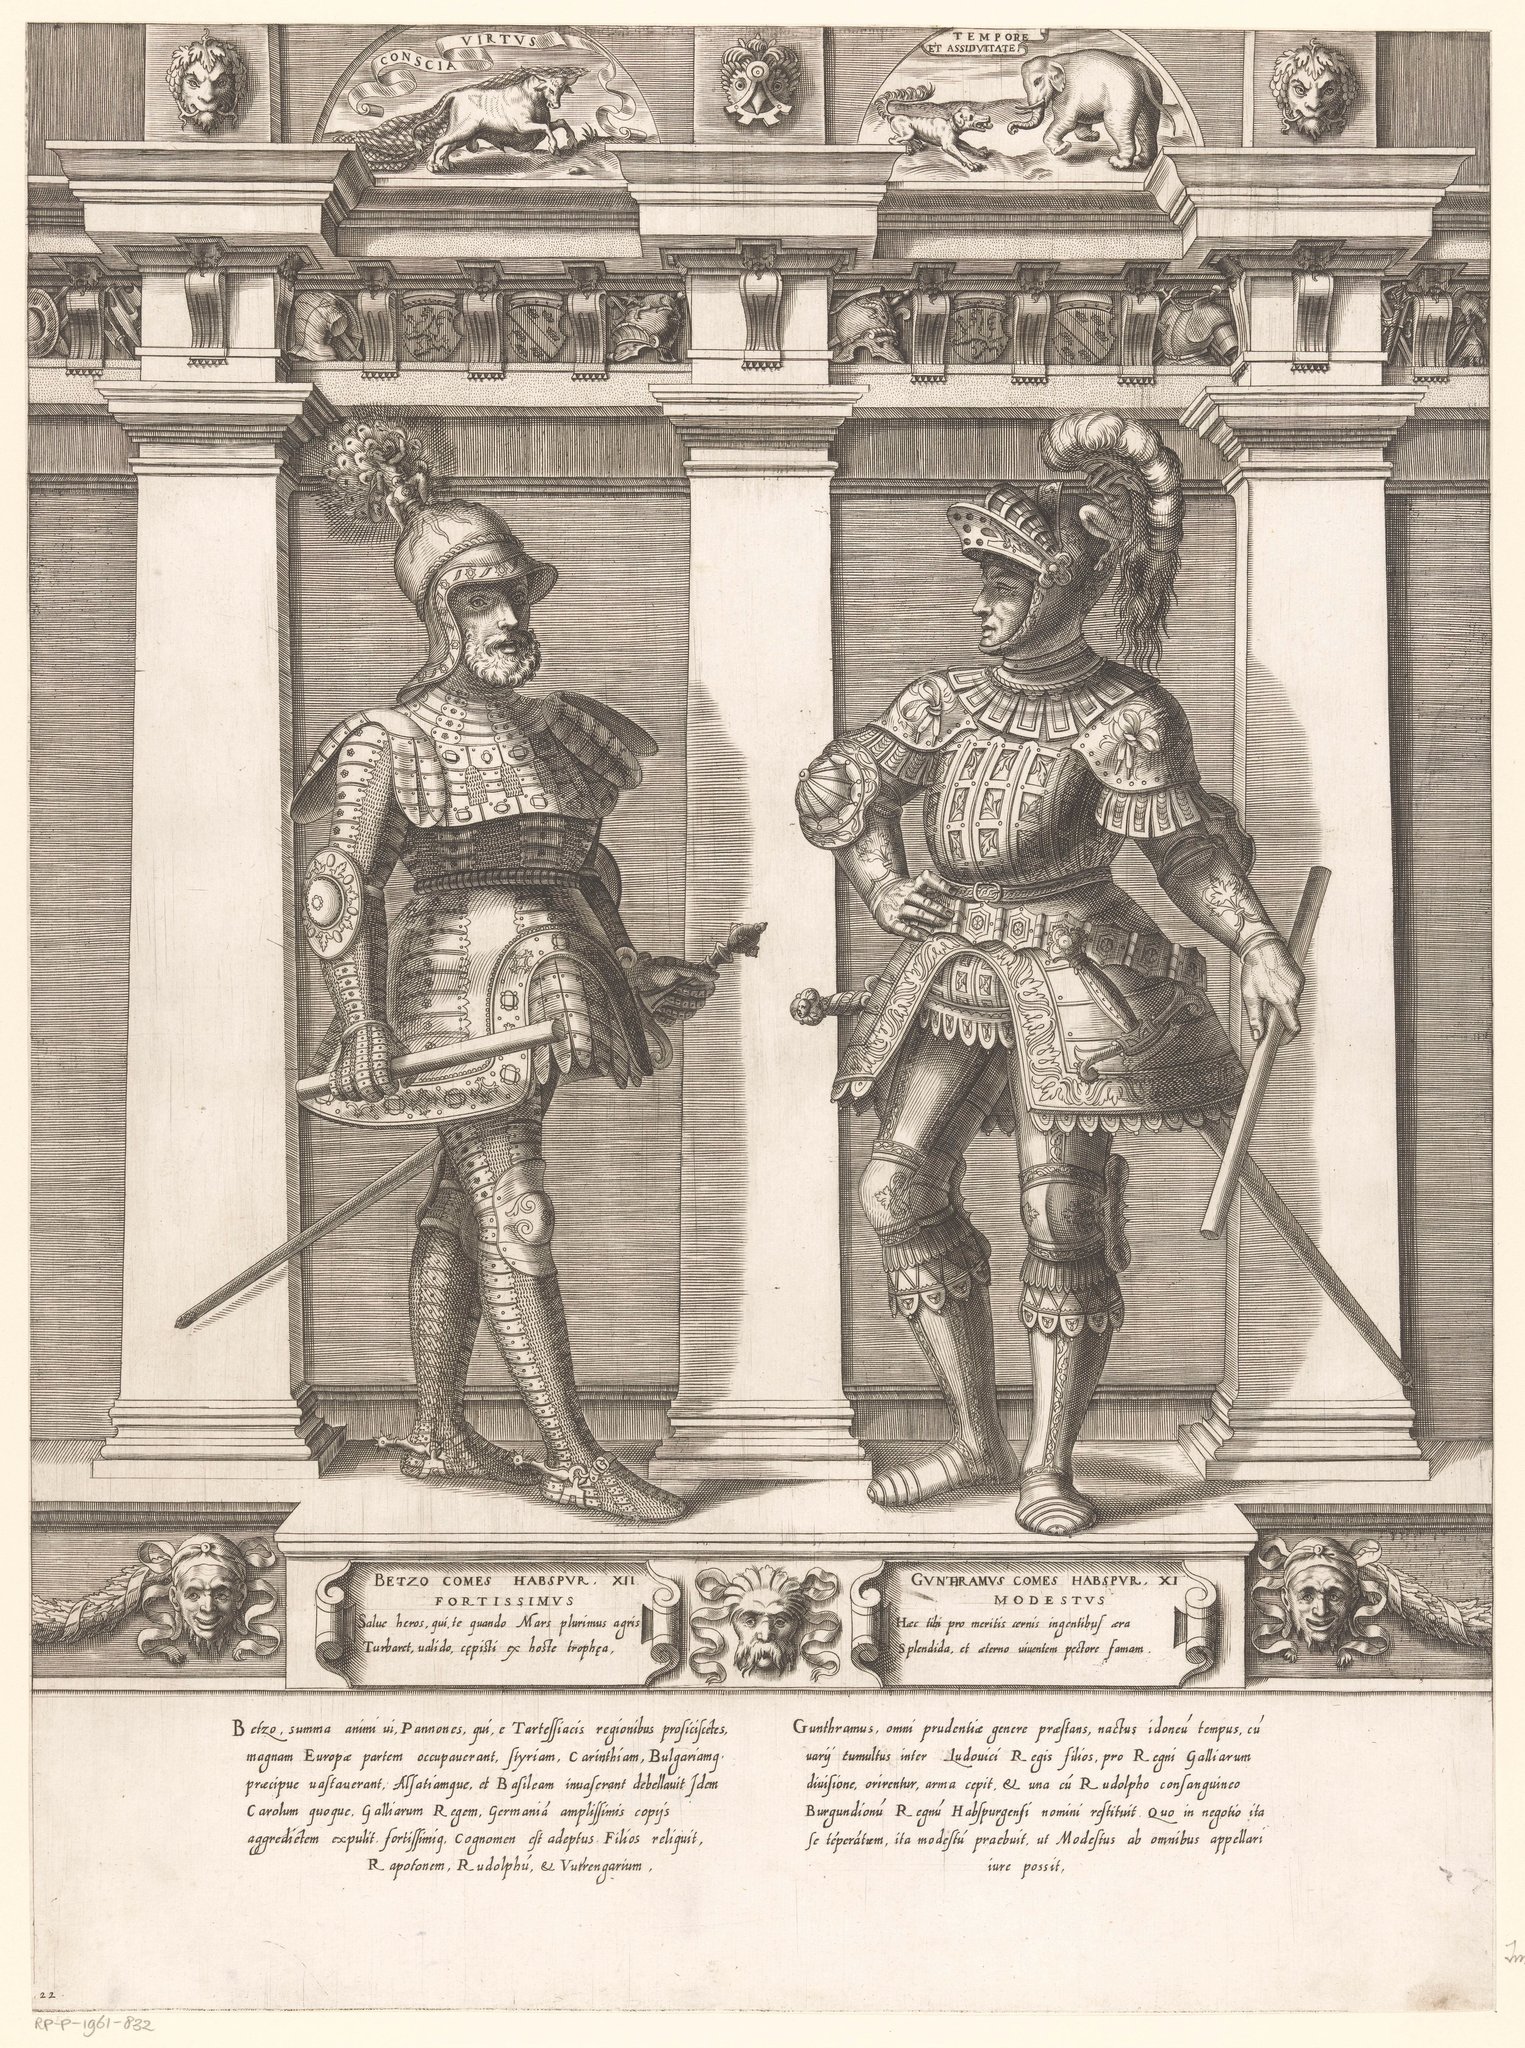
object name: print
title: Portretten van leden van het Oostenrijkse Huis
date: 1569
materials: paper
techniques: engraving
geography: italy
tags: historical persons, ruler, sovereign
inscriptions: collector's mark: Lugt 2228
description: Deze prent maakt deel uit van een reeks van 58 prenten. Het meerendeel van de prenten bevat portretten van 74 leden van het Oostenrijkse Huis, naar tekeningen door Francesco Terzio, die deels getekend zijn naar de 28 levensgrote bronzen beelden die rond de cenotaaf van Maximiliaan I in de Hofkirche te Innsbruck staan.